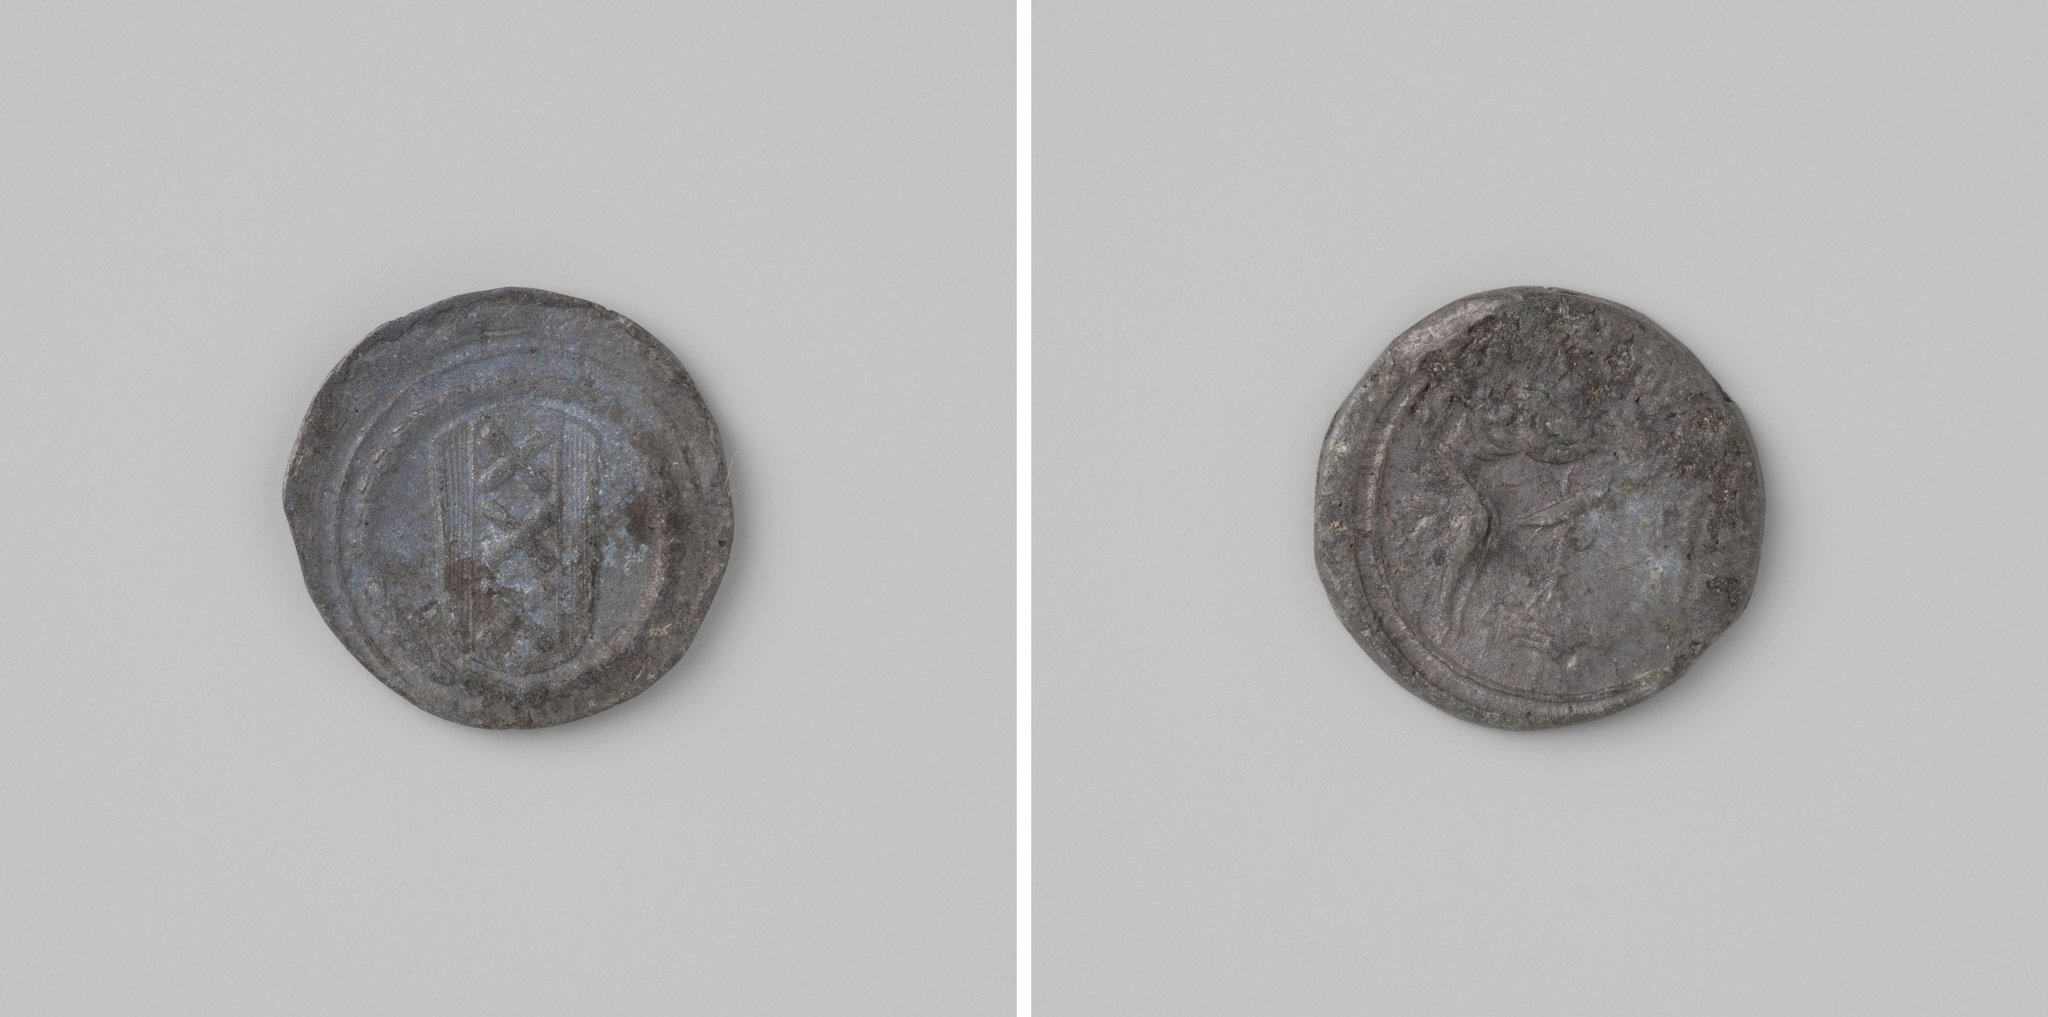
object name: medal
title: Stad Amsterdam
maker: Anonymous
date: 1586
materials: lead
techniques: striking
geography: amsterdam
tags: amsterdam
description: Loden penning. Voorzijde: wapenschild binnen bladerkrans. Keerzijde: twee ineengeslagen handen uit wolken houden gezamelijk anker vast; links onder: jaartal binnen parelrand